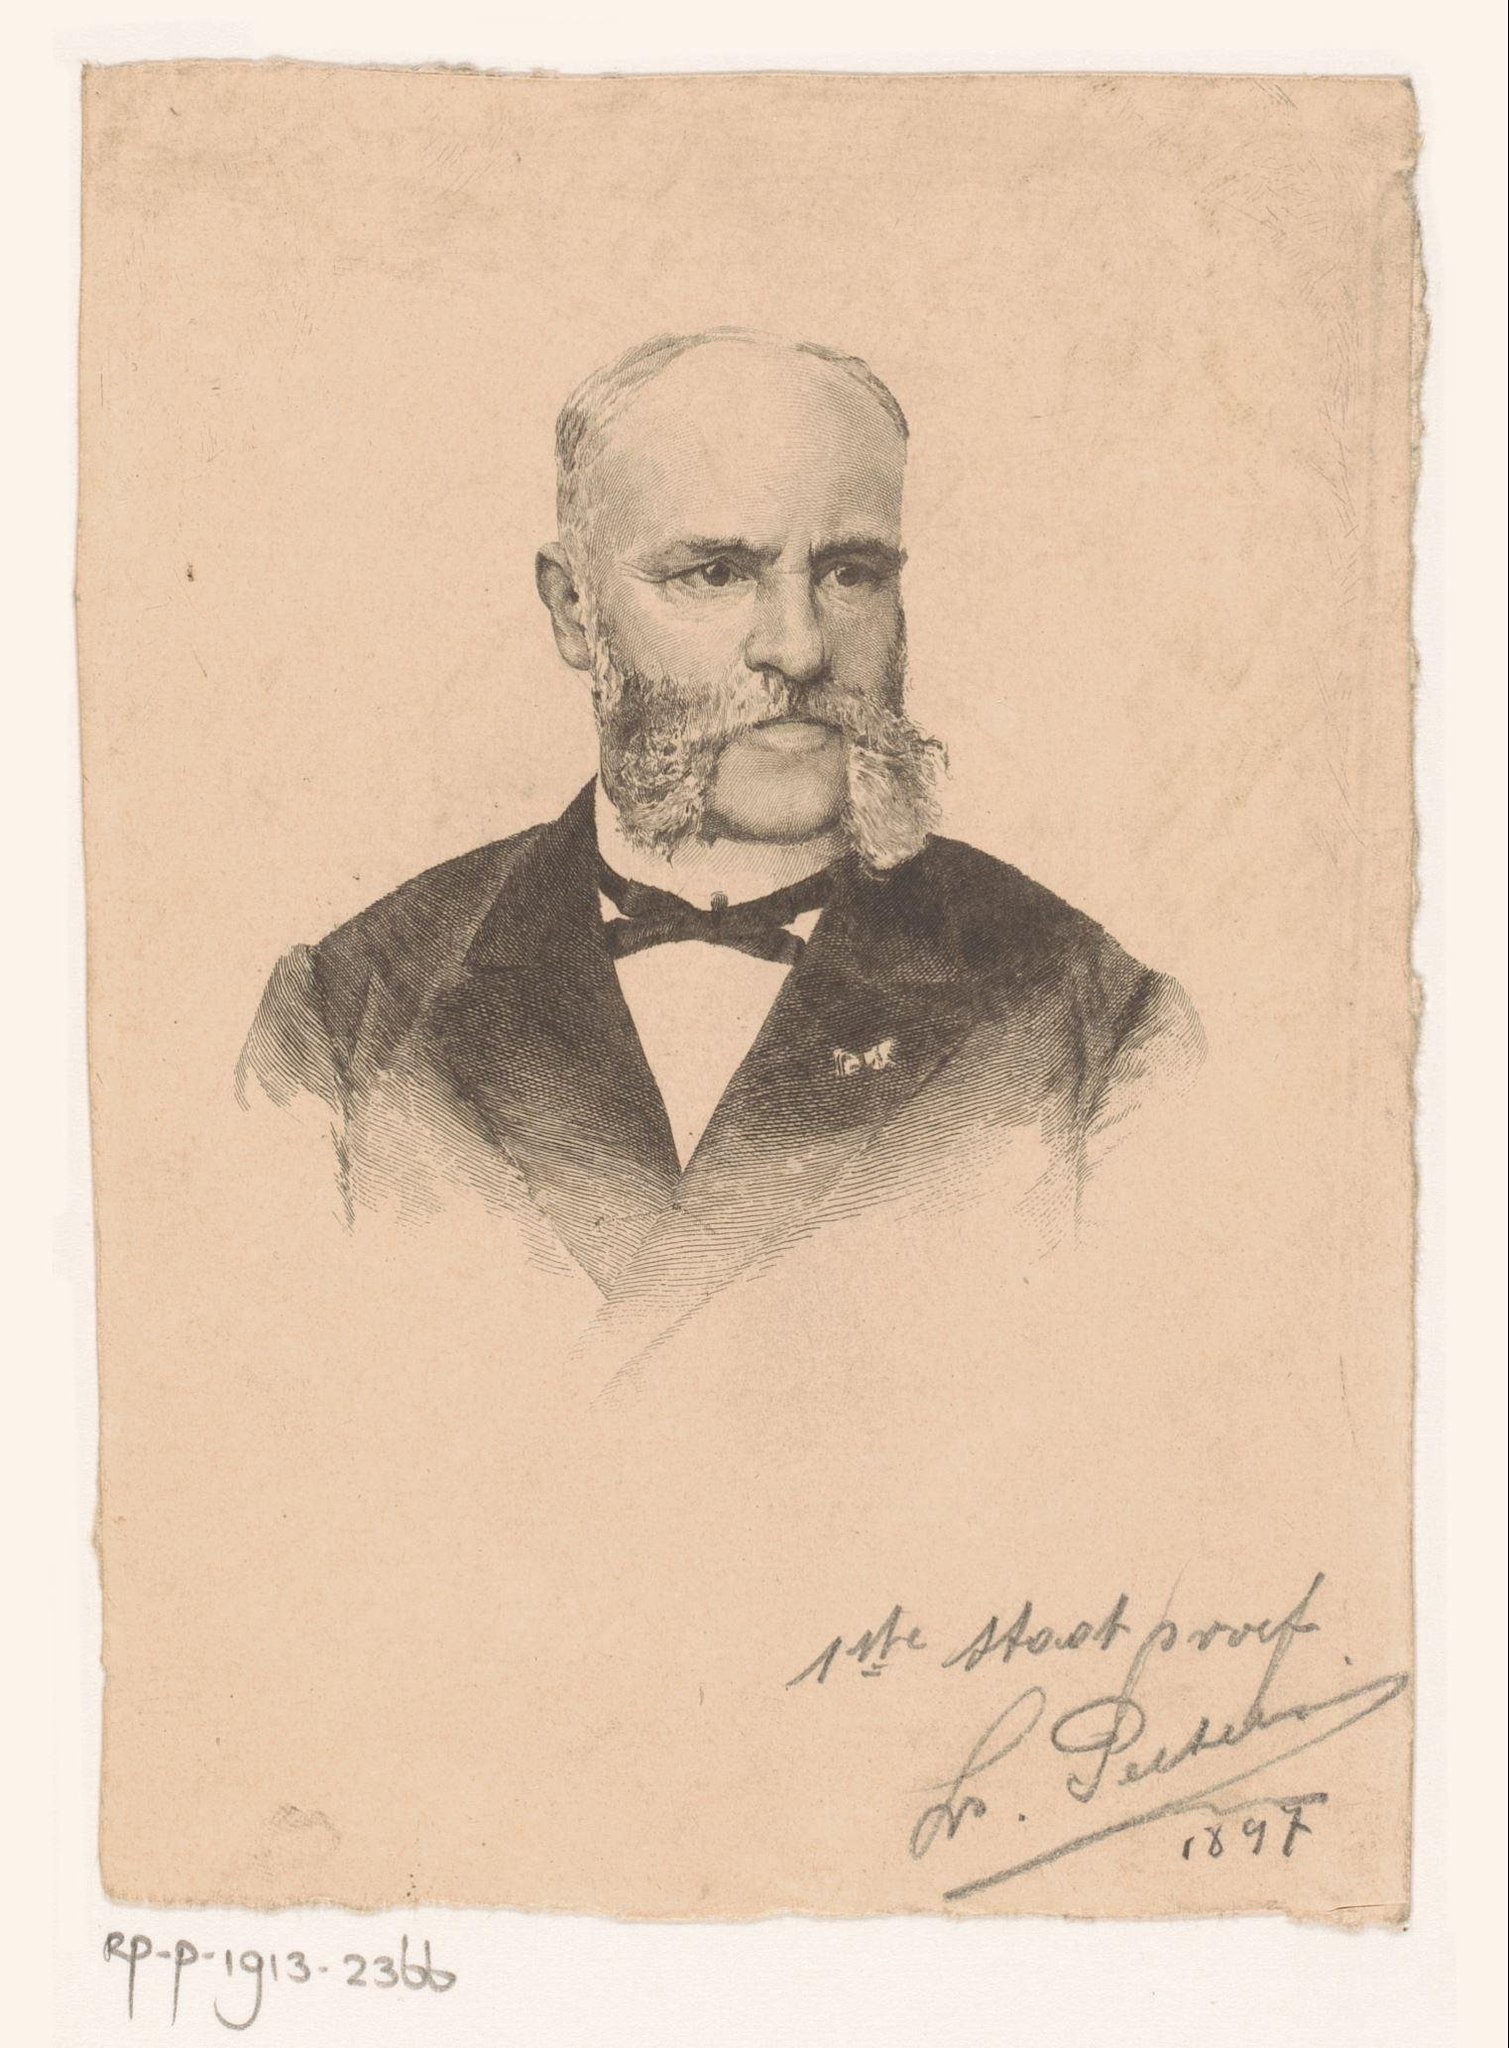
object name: print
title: Portret van een onbekende man, mogelijk Montigny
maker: louis peeters (i)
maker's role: print maker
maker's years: 1876-1964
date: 1897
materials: paper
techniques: etching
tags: anonymous historical person portrayed alone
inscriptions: annotation: ‘1ste staat proef’, collector's mark: Lugt 2228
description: Geboorte- en sterfdatum van de prentmaker zijn onbekend. Daarom is voor de bepaling van de rechten van dit object gebruik gemaakt van de verwervingsdatum Rijksmuseum Amsterdam.